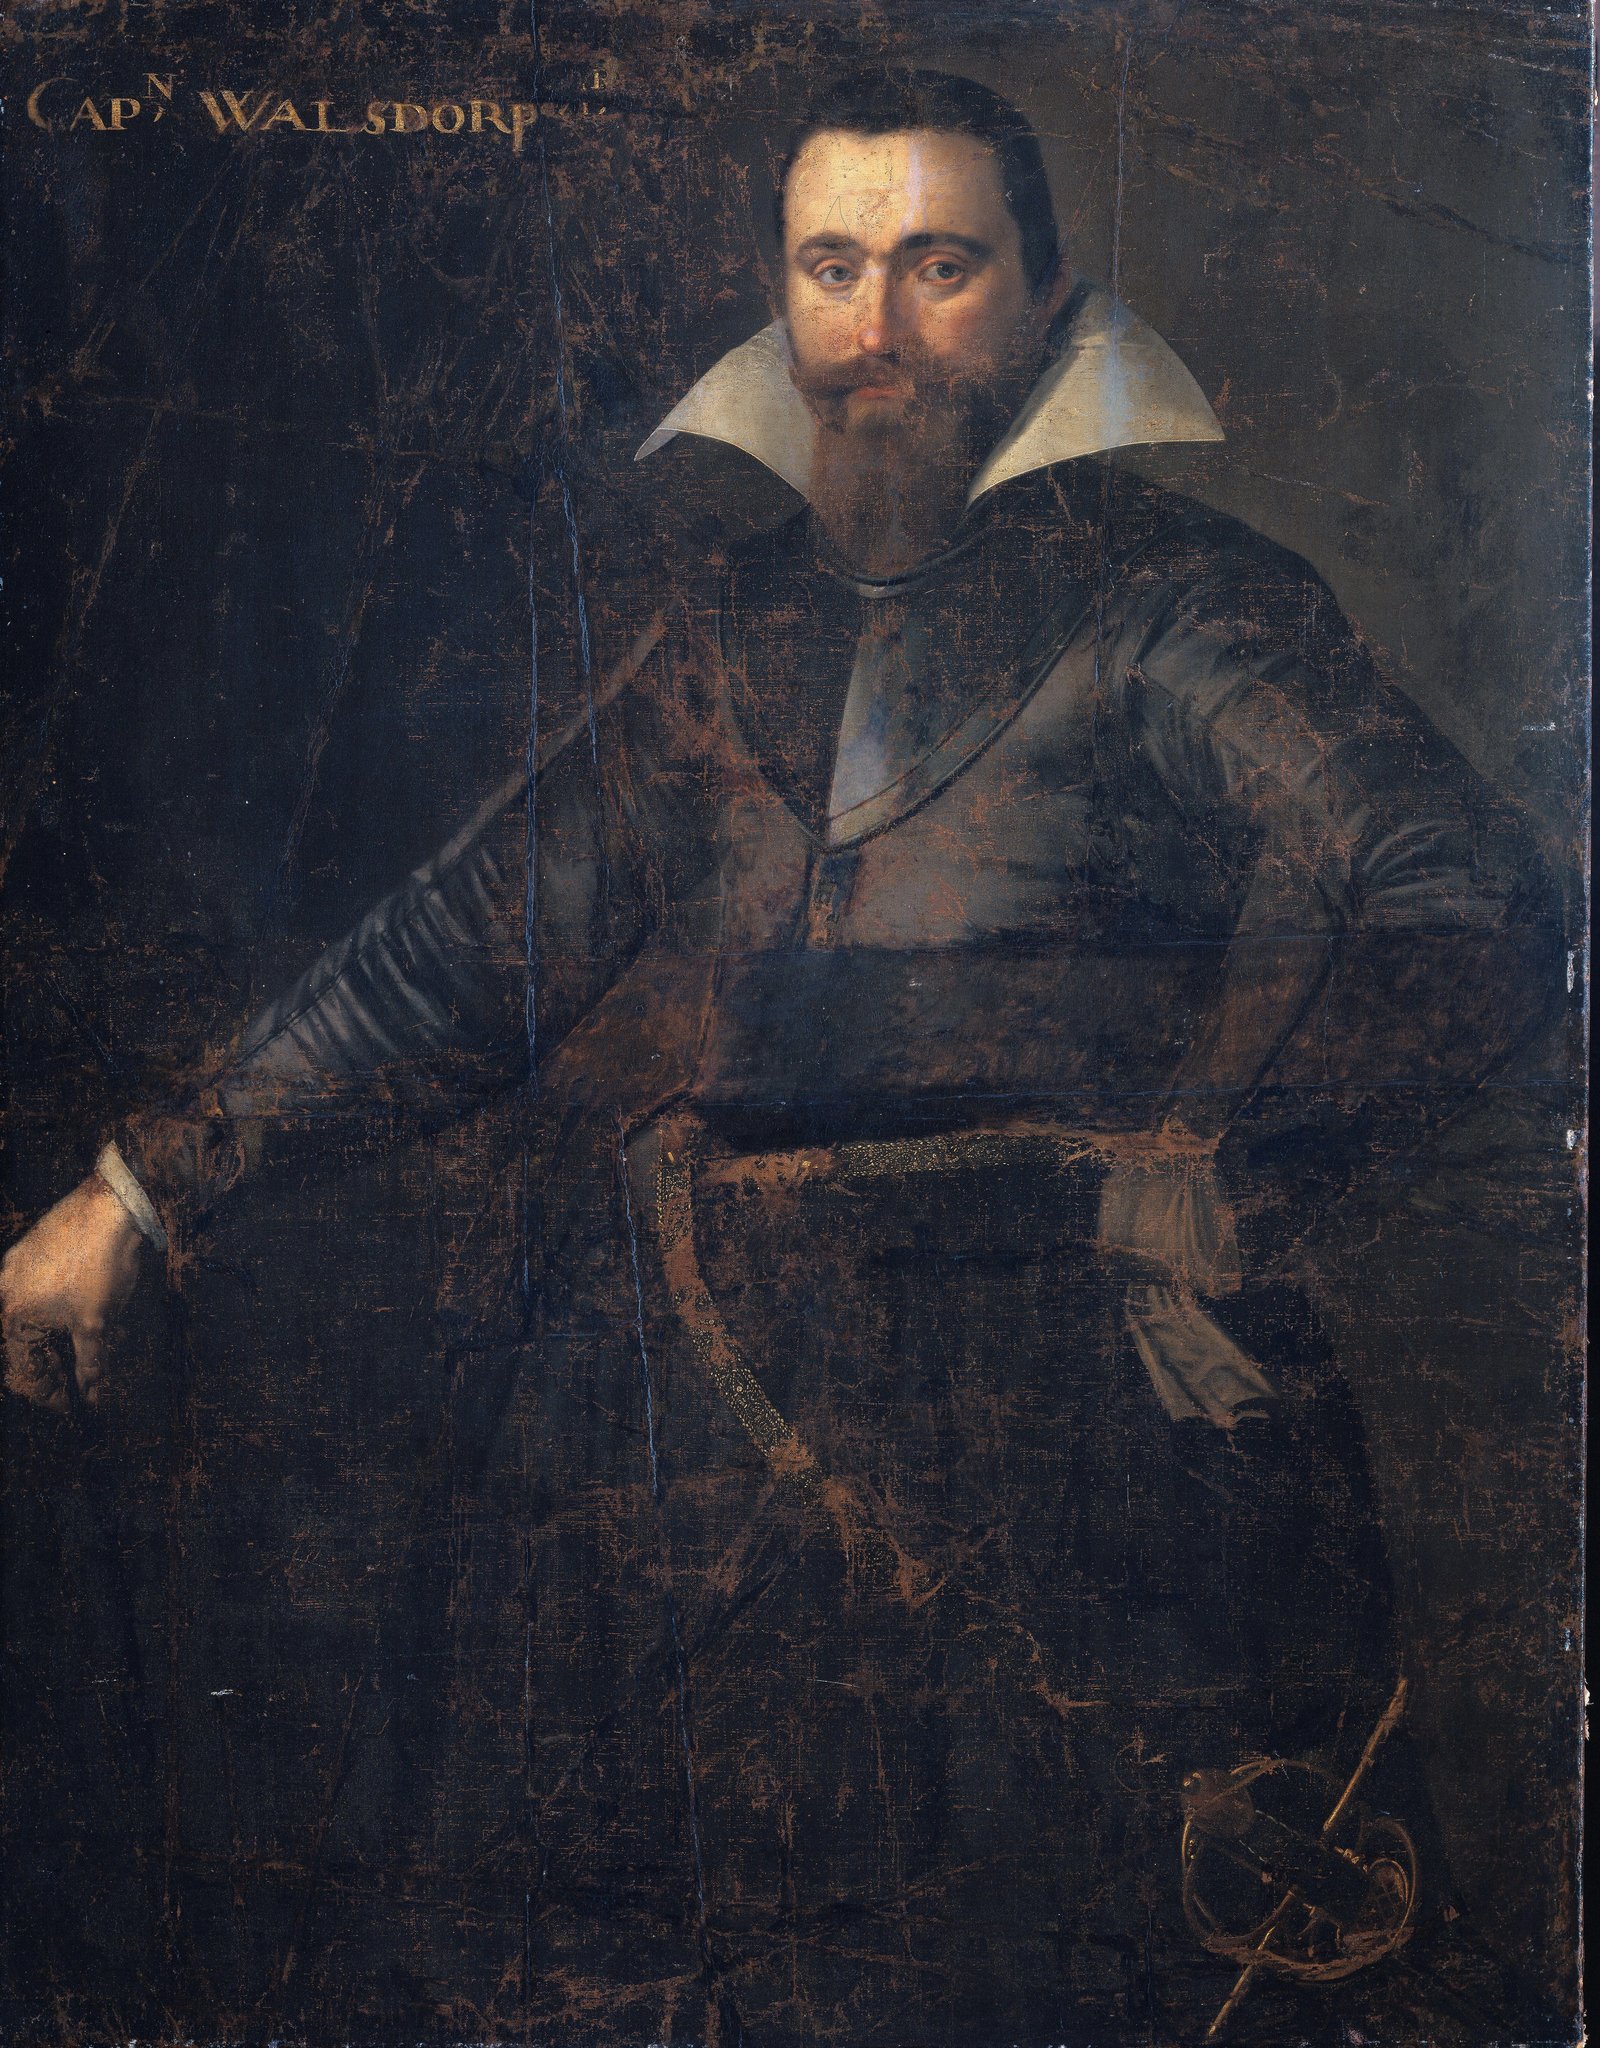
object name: painting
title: Portrait of Bartholomeus Andrio Walsdorffer (?-1622)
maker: Anonymous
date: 1605-1615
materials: canvas, oil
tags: historical persons, bergen op zoom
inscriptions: inscription, top left: ‘CAP,N. WALSDORP[…]R’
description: Portret van Bartolomeus Andrio Walsdorffer (?-1622). Kapitein van een compagnie Zwitsers ter repartitie van Friesland. Gesneuveld bij Bergen op Zoom. Kniestuk, staand, de rechterhand steunend op een stok, de linkerhand in de zij.